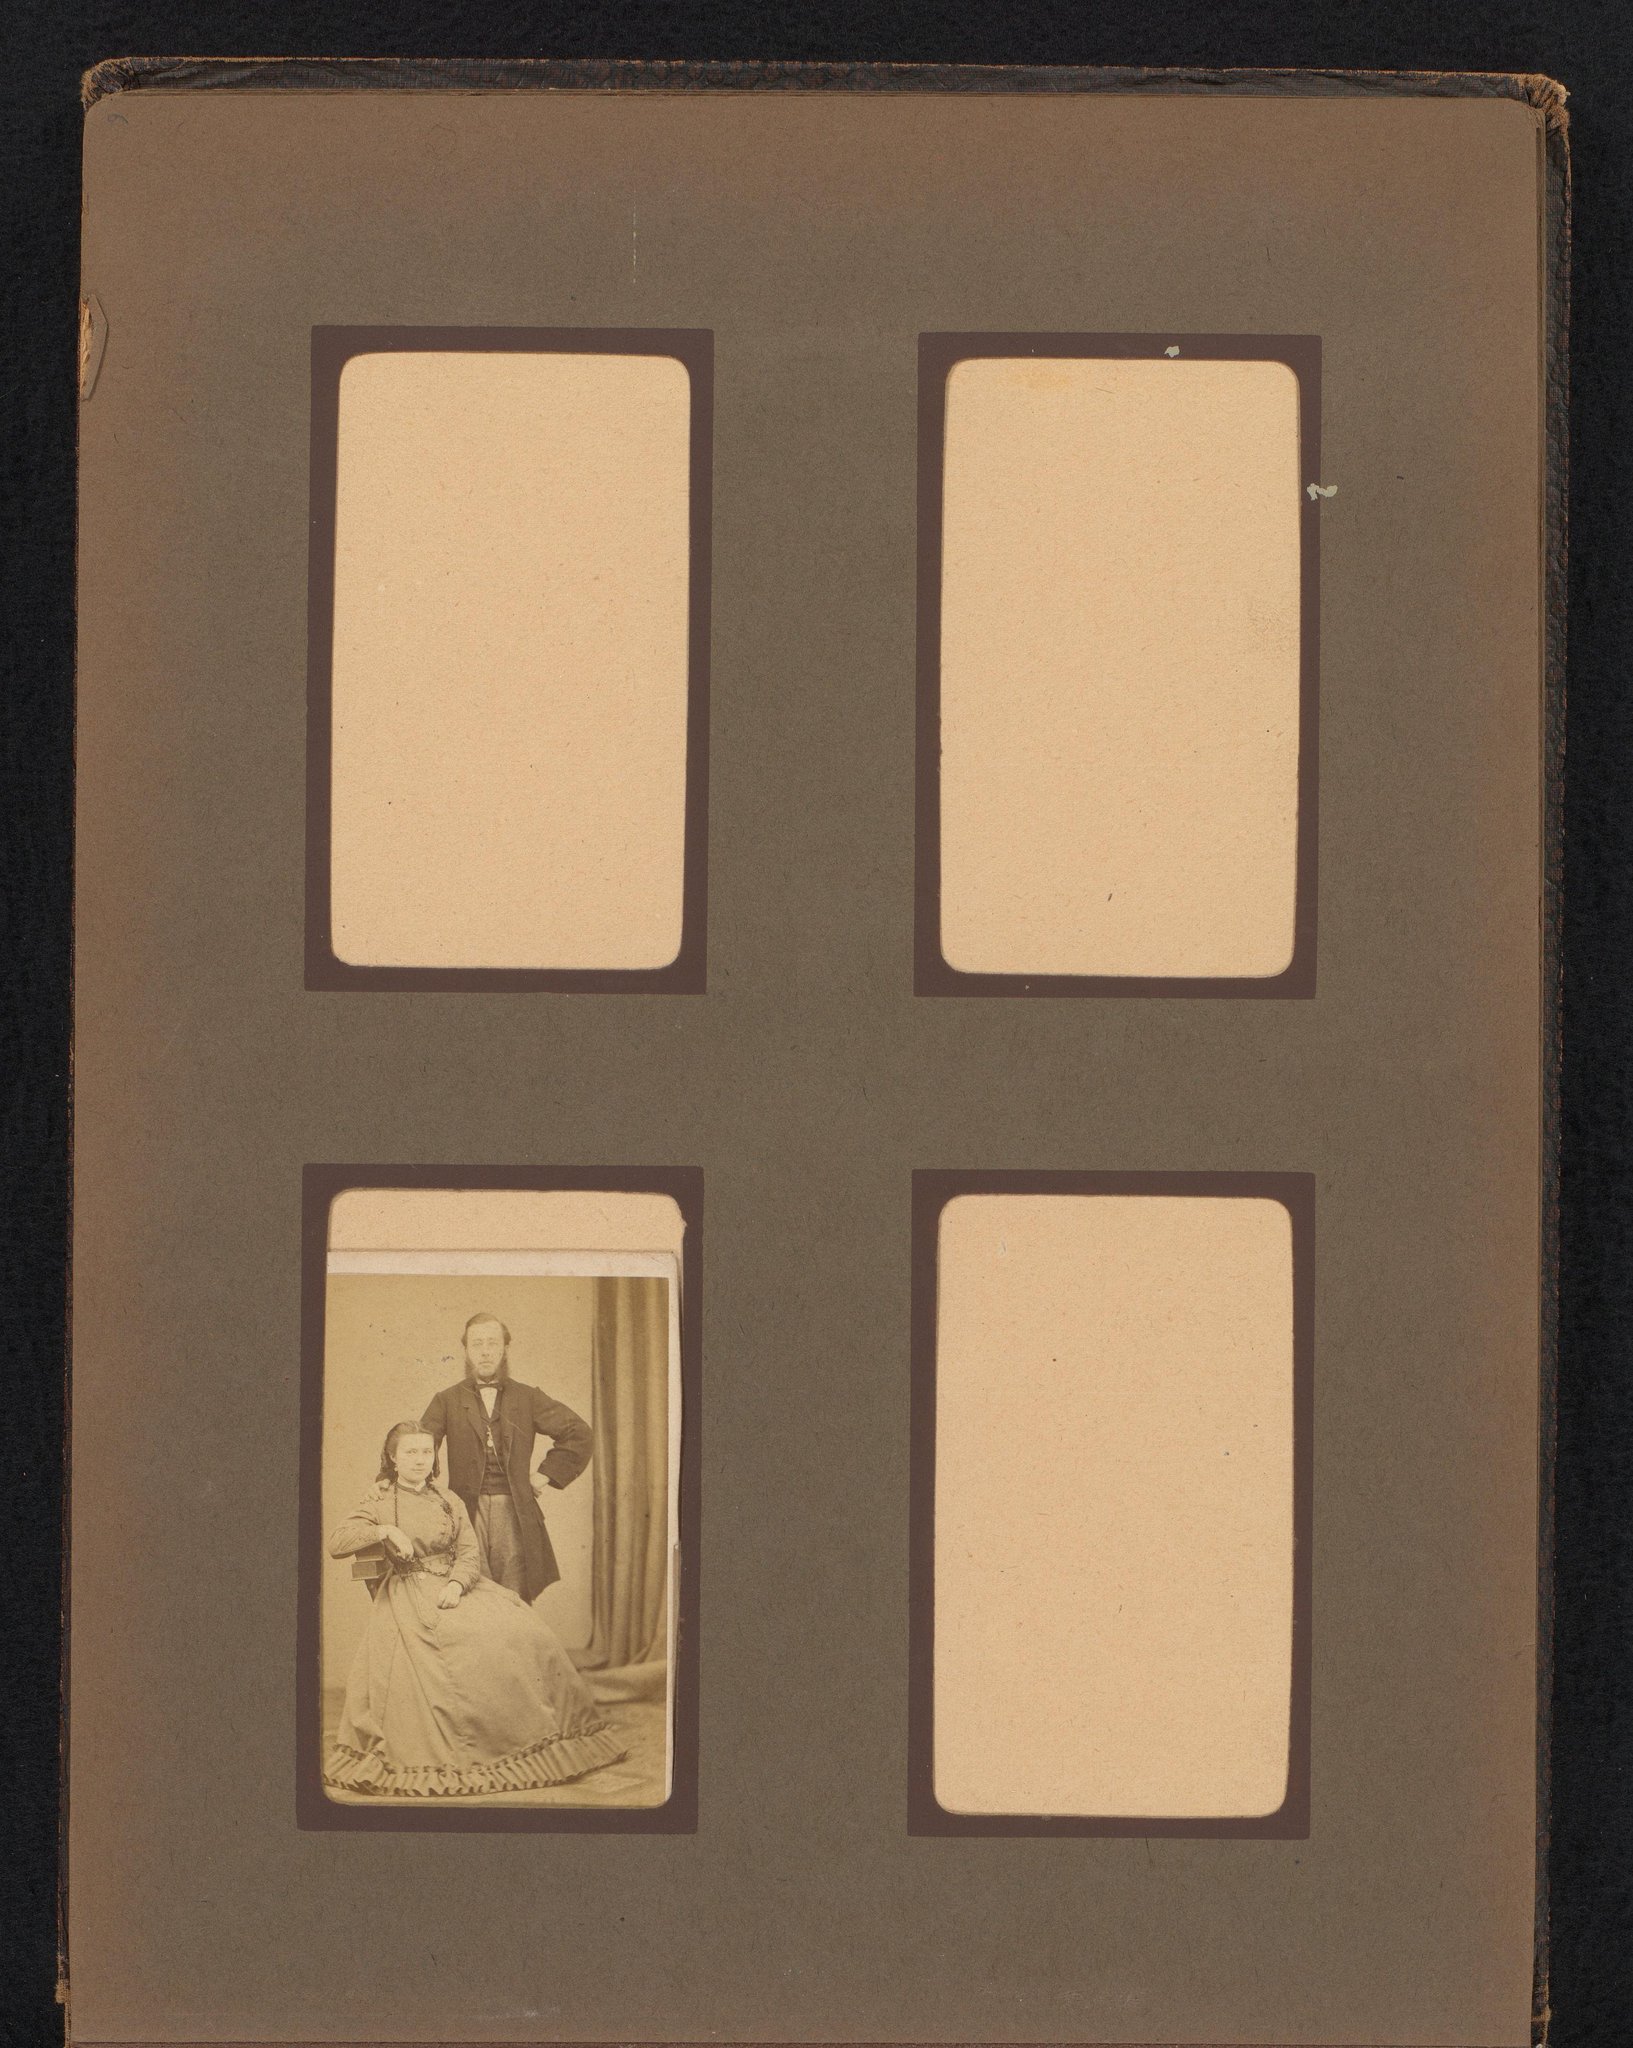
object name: photograph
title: Portret van een man en vrouw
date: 1867-1870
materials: cardboard, paper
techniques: albumen print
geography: amsterdam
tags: historical persons not known by name - bb - woman, historical persons not known by name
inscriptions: inscription: ‘Photographisch Etablissement/ C. Stapert & van Caspel./ Bloemgracht D.D.43/ Amsterdam’